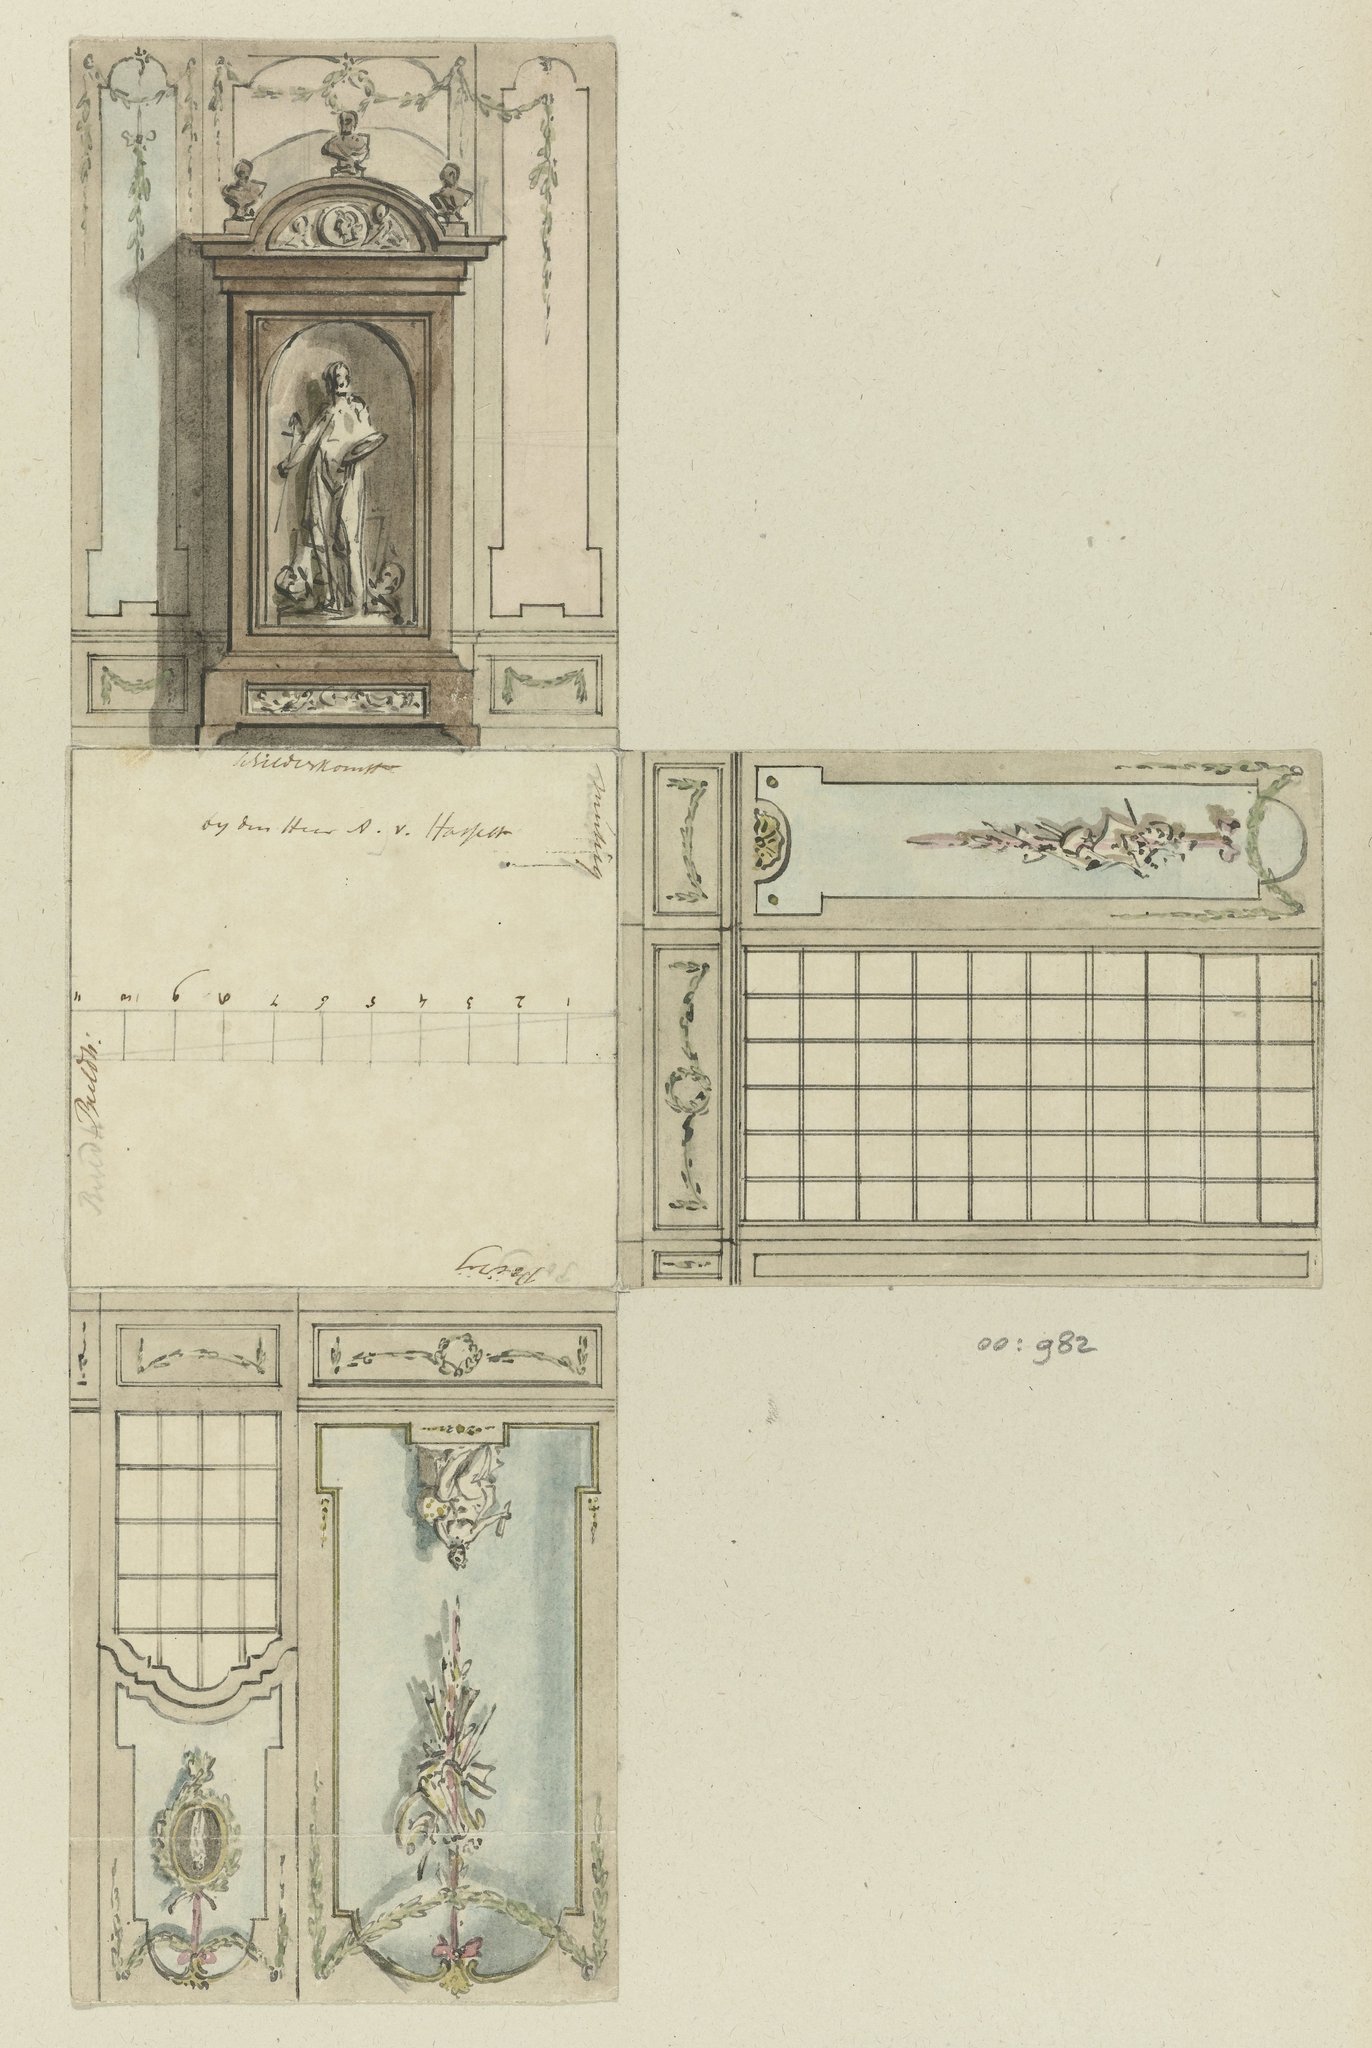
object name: design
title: Ontwerp voor een kabinetje bij Arent van Hasselt, Keizersgracht 584, Amsterdam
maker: jurriaan andriessen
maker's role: draughtsman, painter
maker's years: 1742-1819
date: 1783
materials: ink, paper, pencil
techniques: brush, pen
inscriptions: annotation: ‘Poezij’, annotation: ‘Muzicq’, annotation: ‘1 2 3 4 5 6 7 8 9 10 11’, annotation: ‘Beeldh’, annotation: ‘Schilderkonst // bij den Heer A v Hasselt’